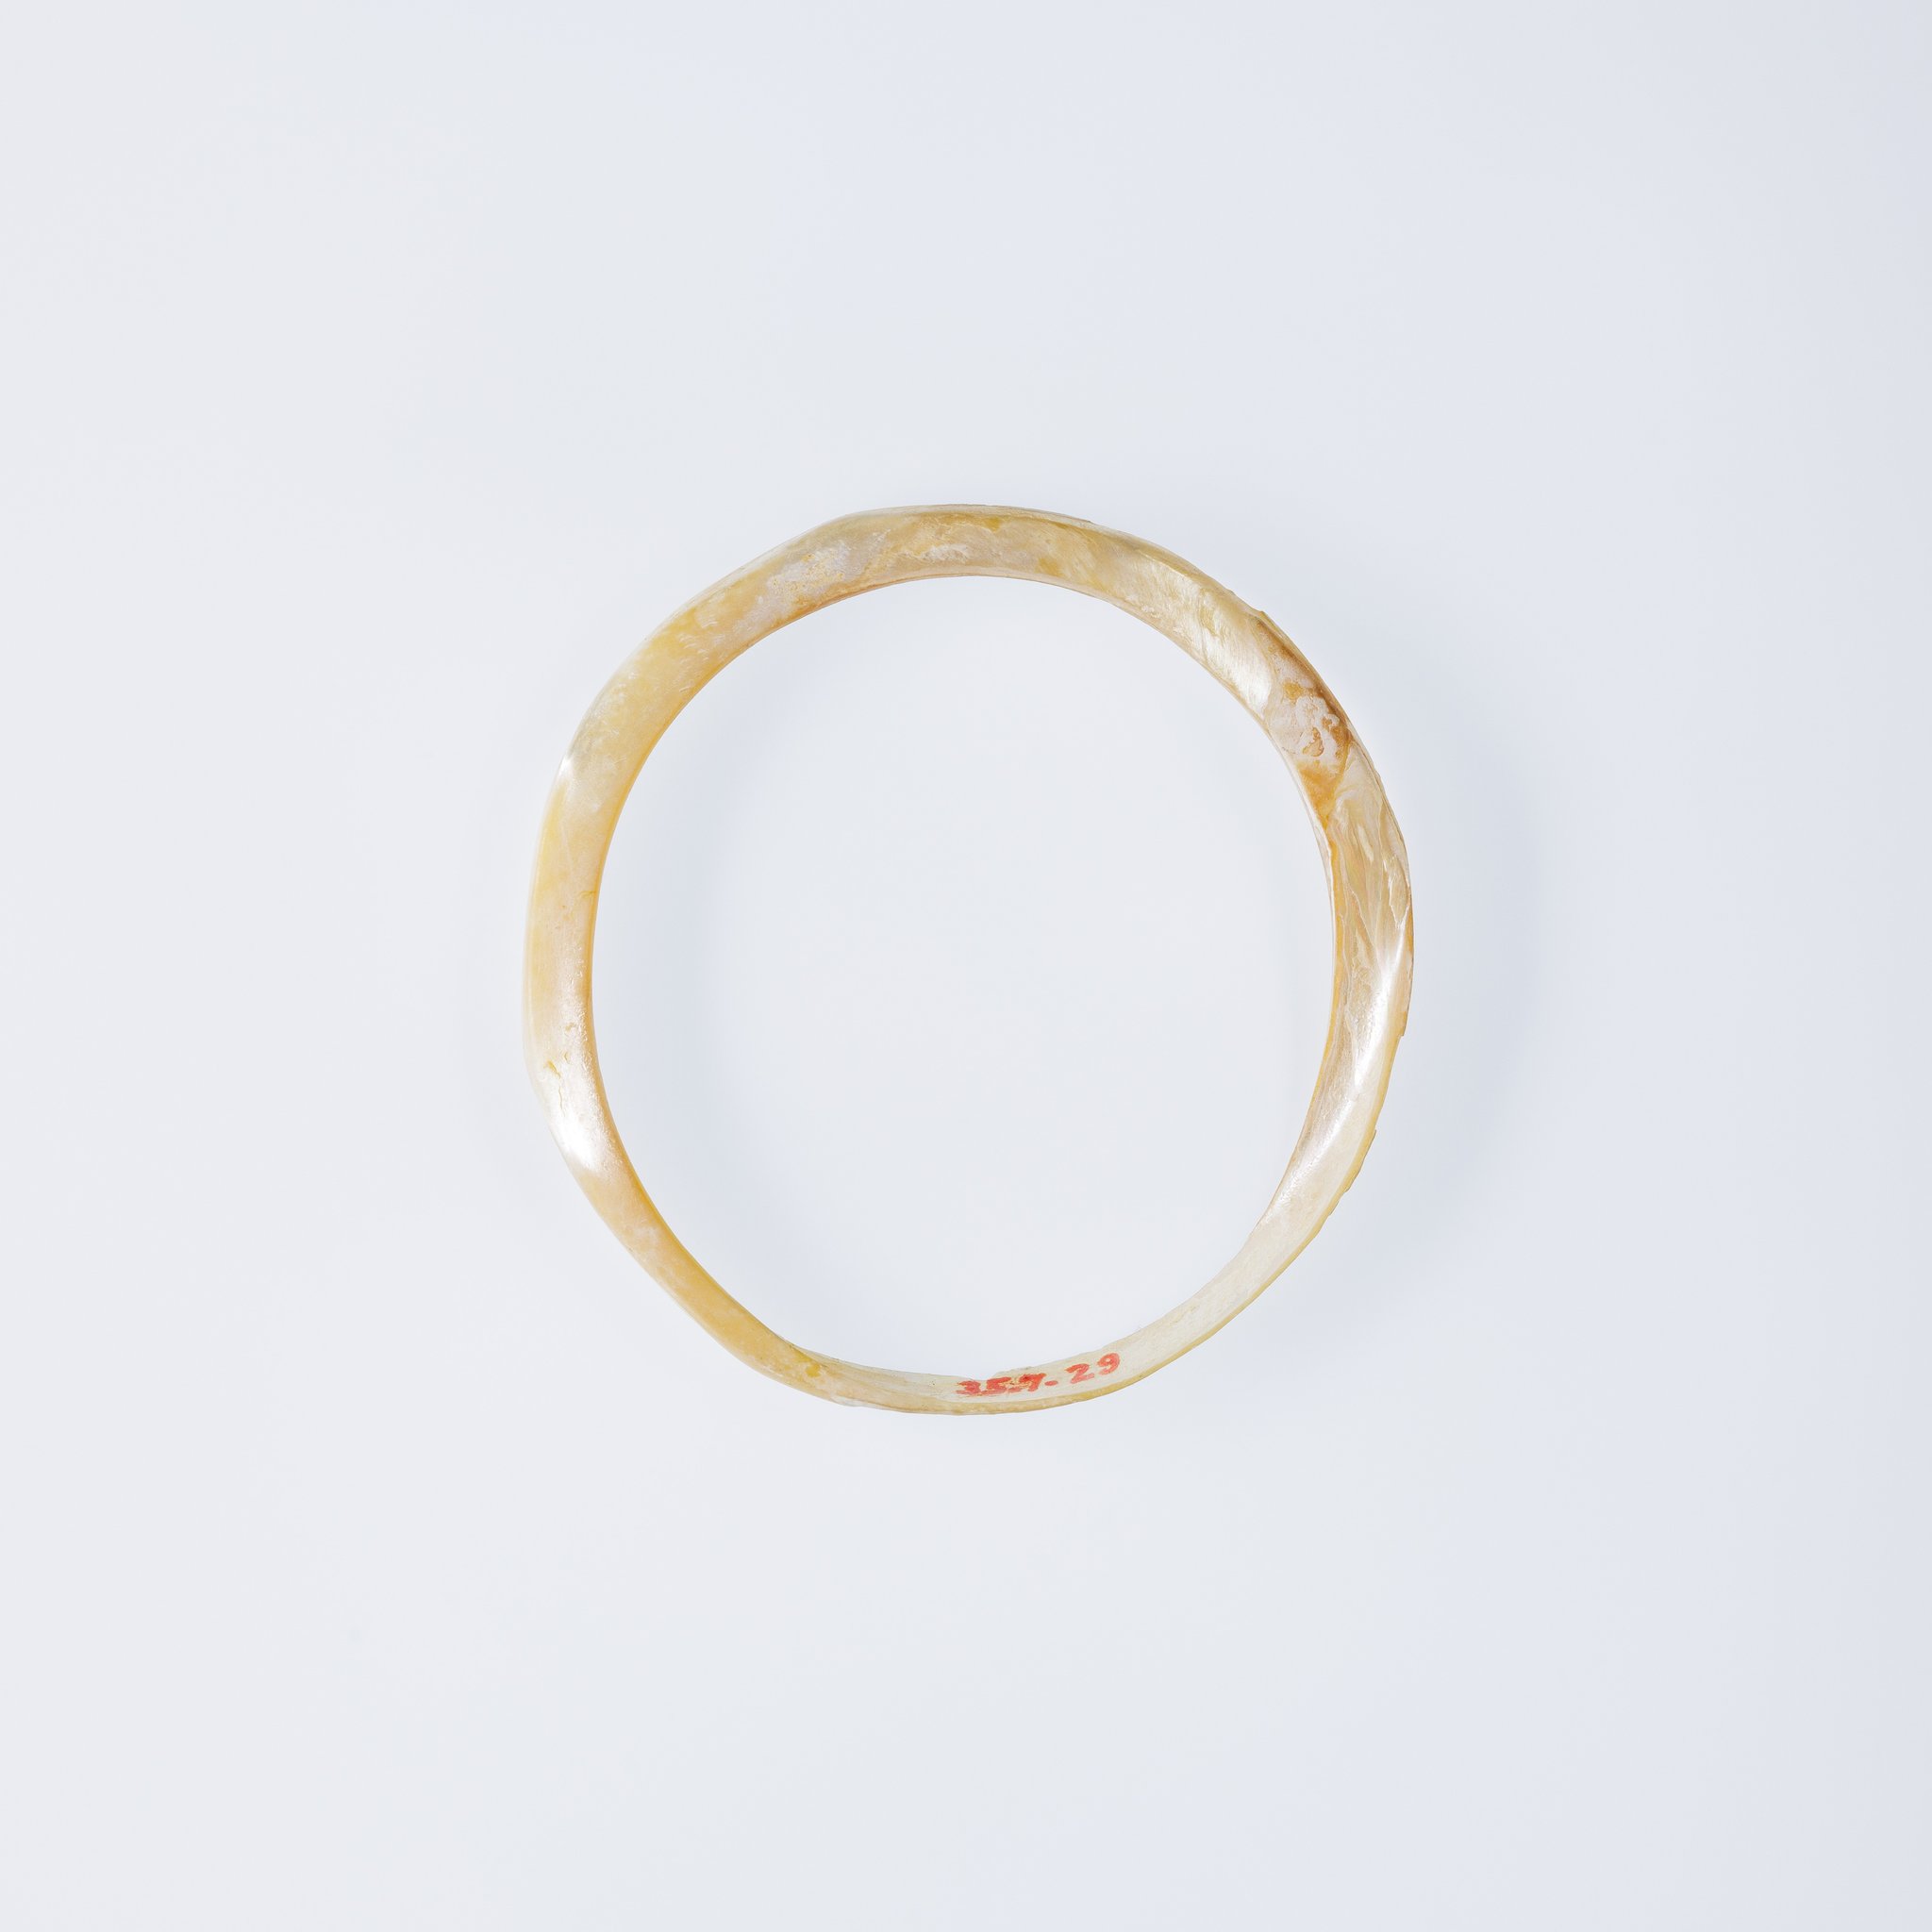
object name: bracelet bangle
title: Bangle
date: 3500-3300 BCE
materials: shell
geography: egypt